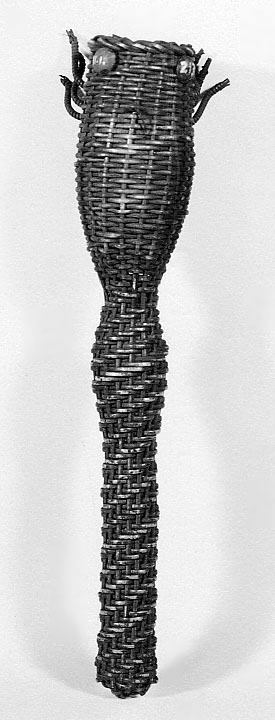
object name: basket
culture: japanese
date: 1801-1900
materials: bamboo